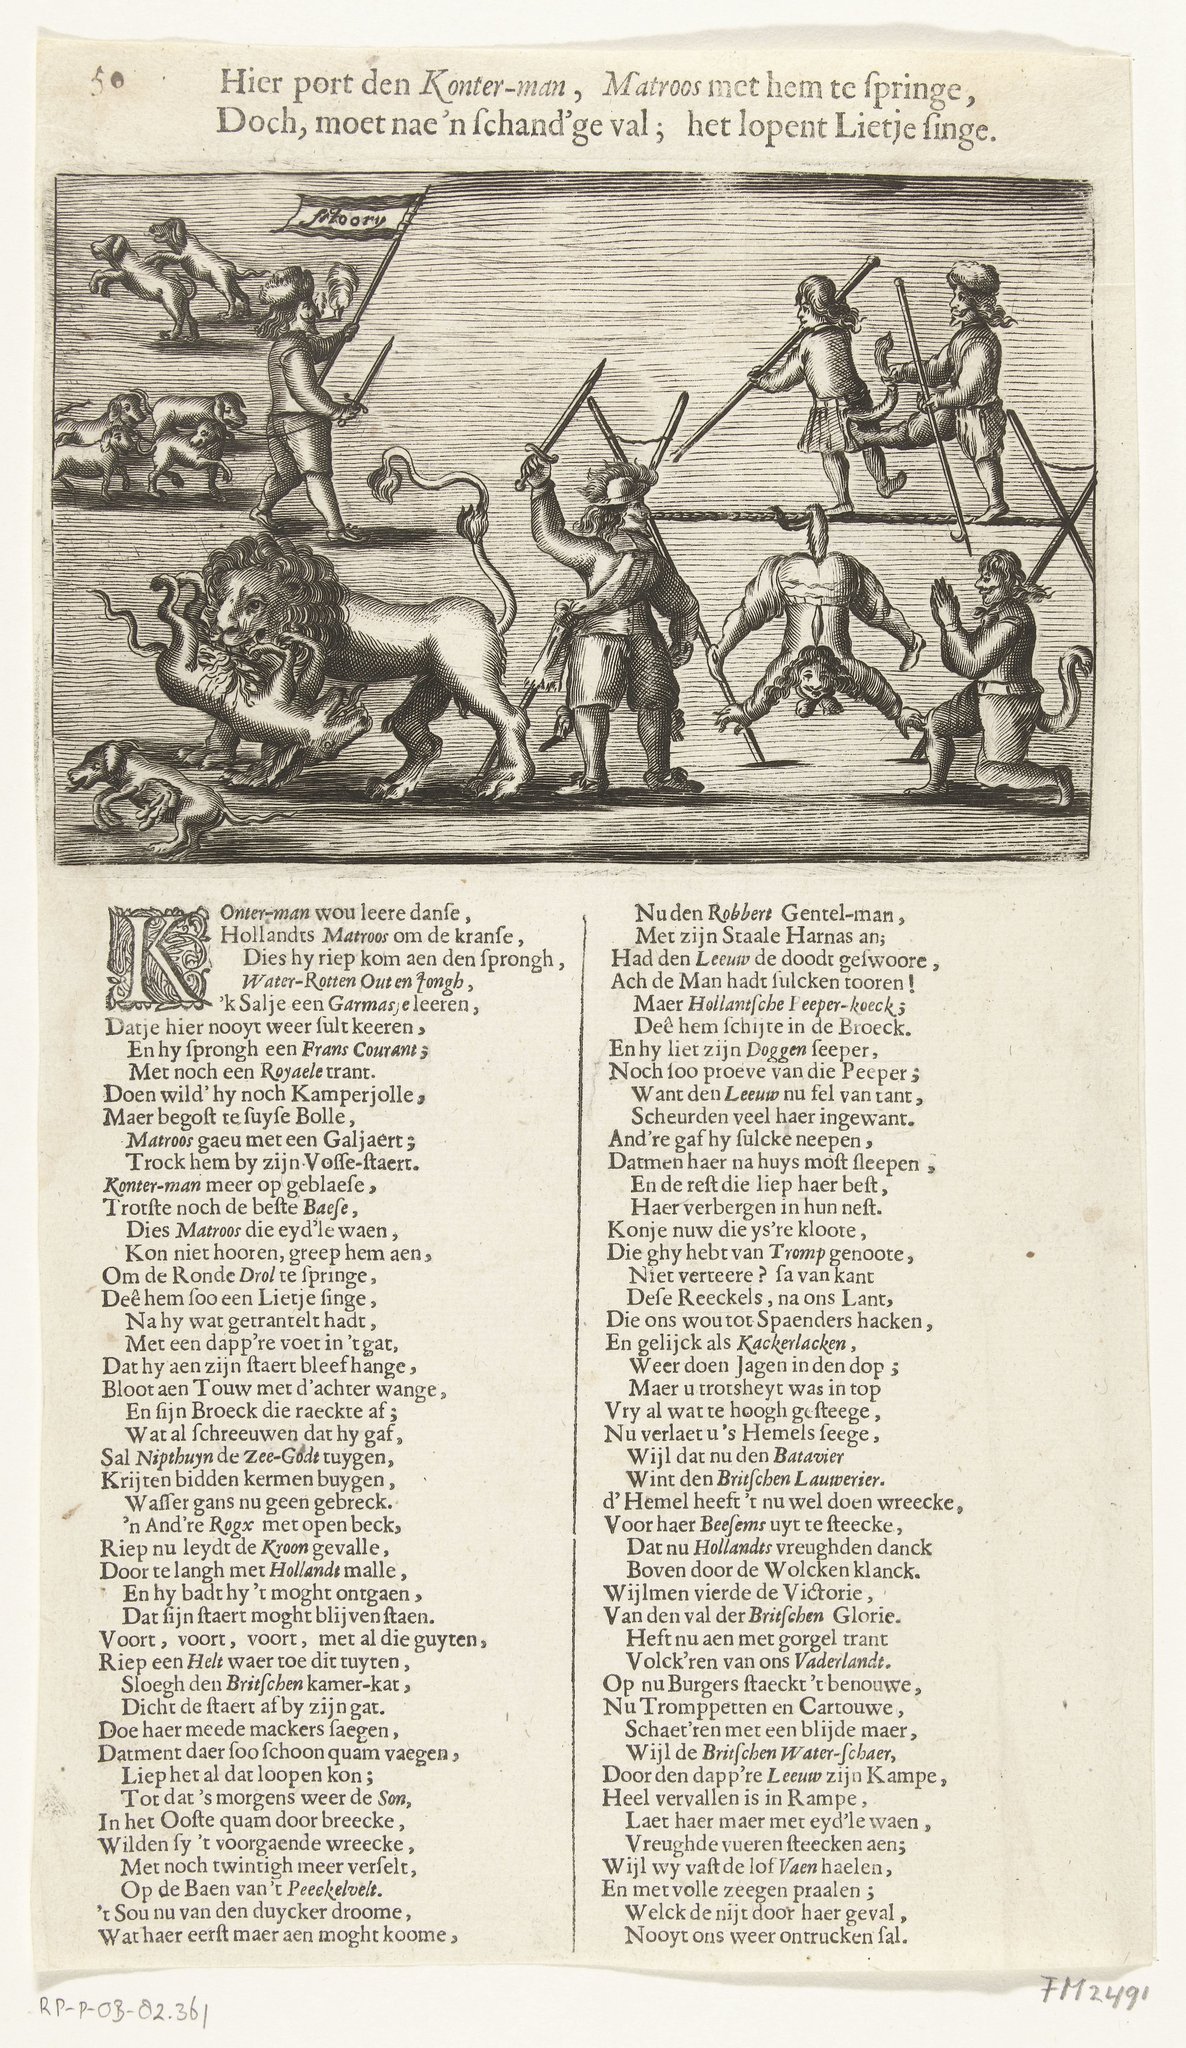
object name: print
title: Hier port den Konter-man, Matroos met hem te springe / Doch, moet nae'n schand'ge val; het lopent Lietje singe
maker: Anonymous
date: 1673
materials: paper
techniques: engraving, letterpress printing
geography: northern netherlands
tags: flushing, michiel adriaenszoon de ruyter, tight-ropewalker, political caricatures and satires, battle of the texel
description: Spotprent op de nederlaag van de Engelsen tegen de Nederlanders in de slag bij Kijkduin op 21 augustus 1673. De Engelse koorddanser (Konterman) krijgt een schop van de Hollandse Matroos. Links verscheurt de Hollandse leeuw Engelse doggen. Onder de plaat een vers in 2 kolommen.